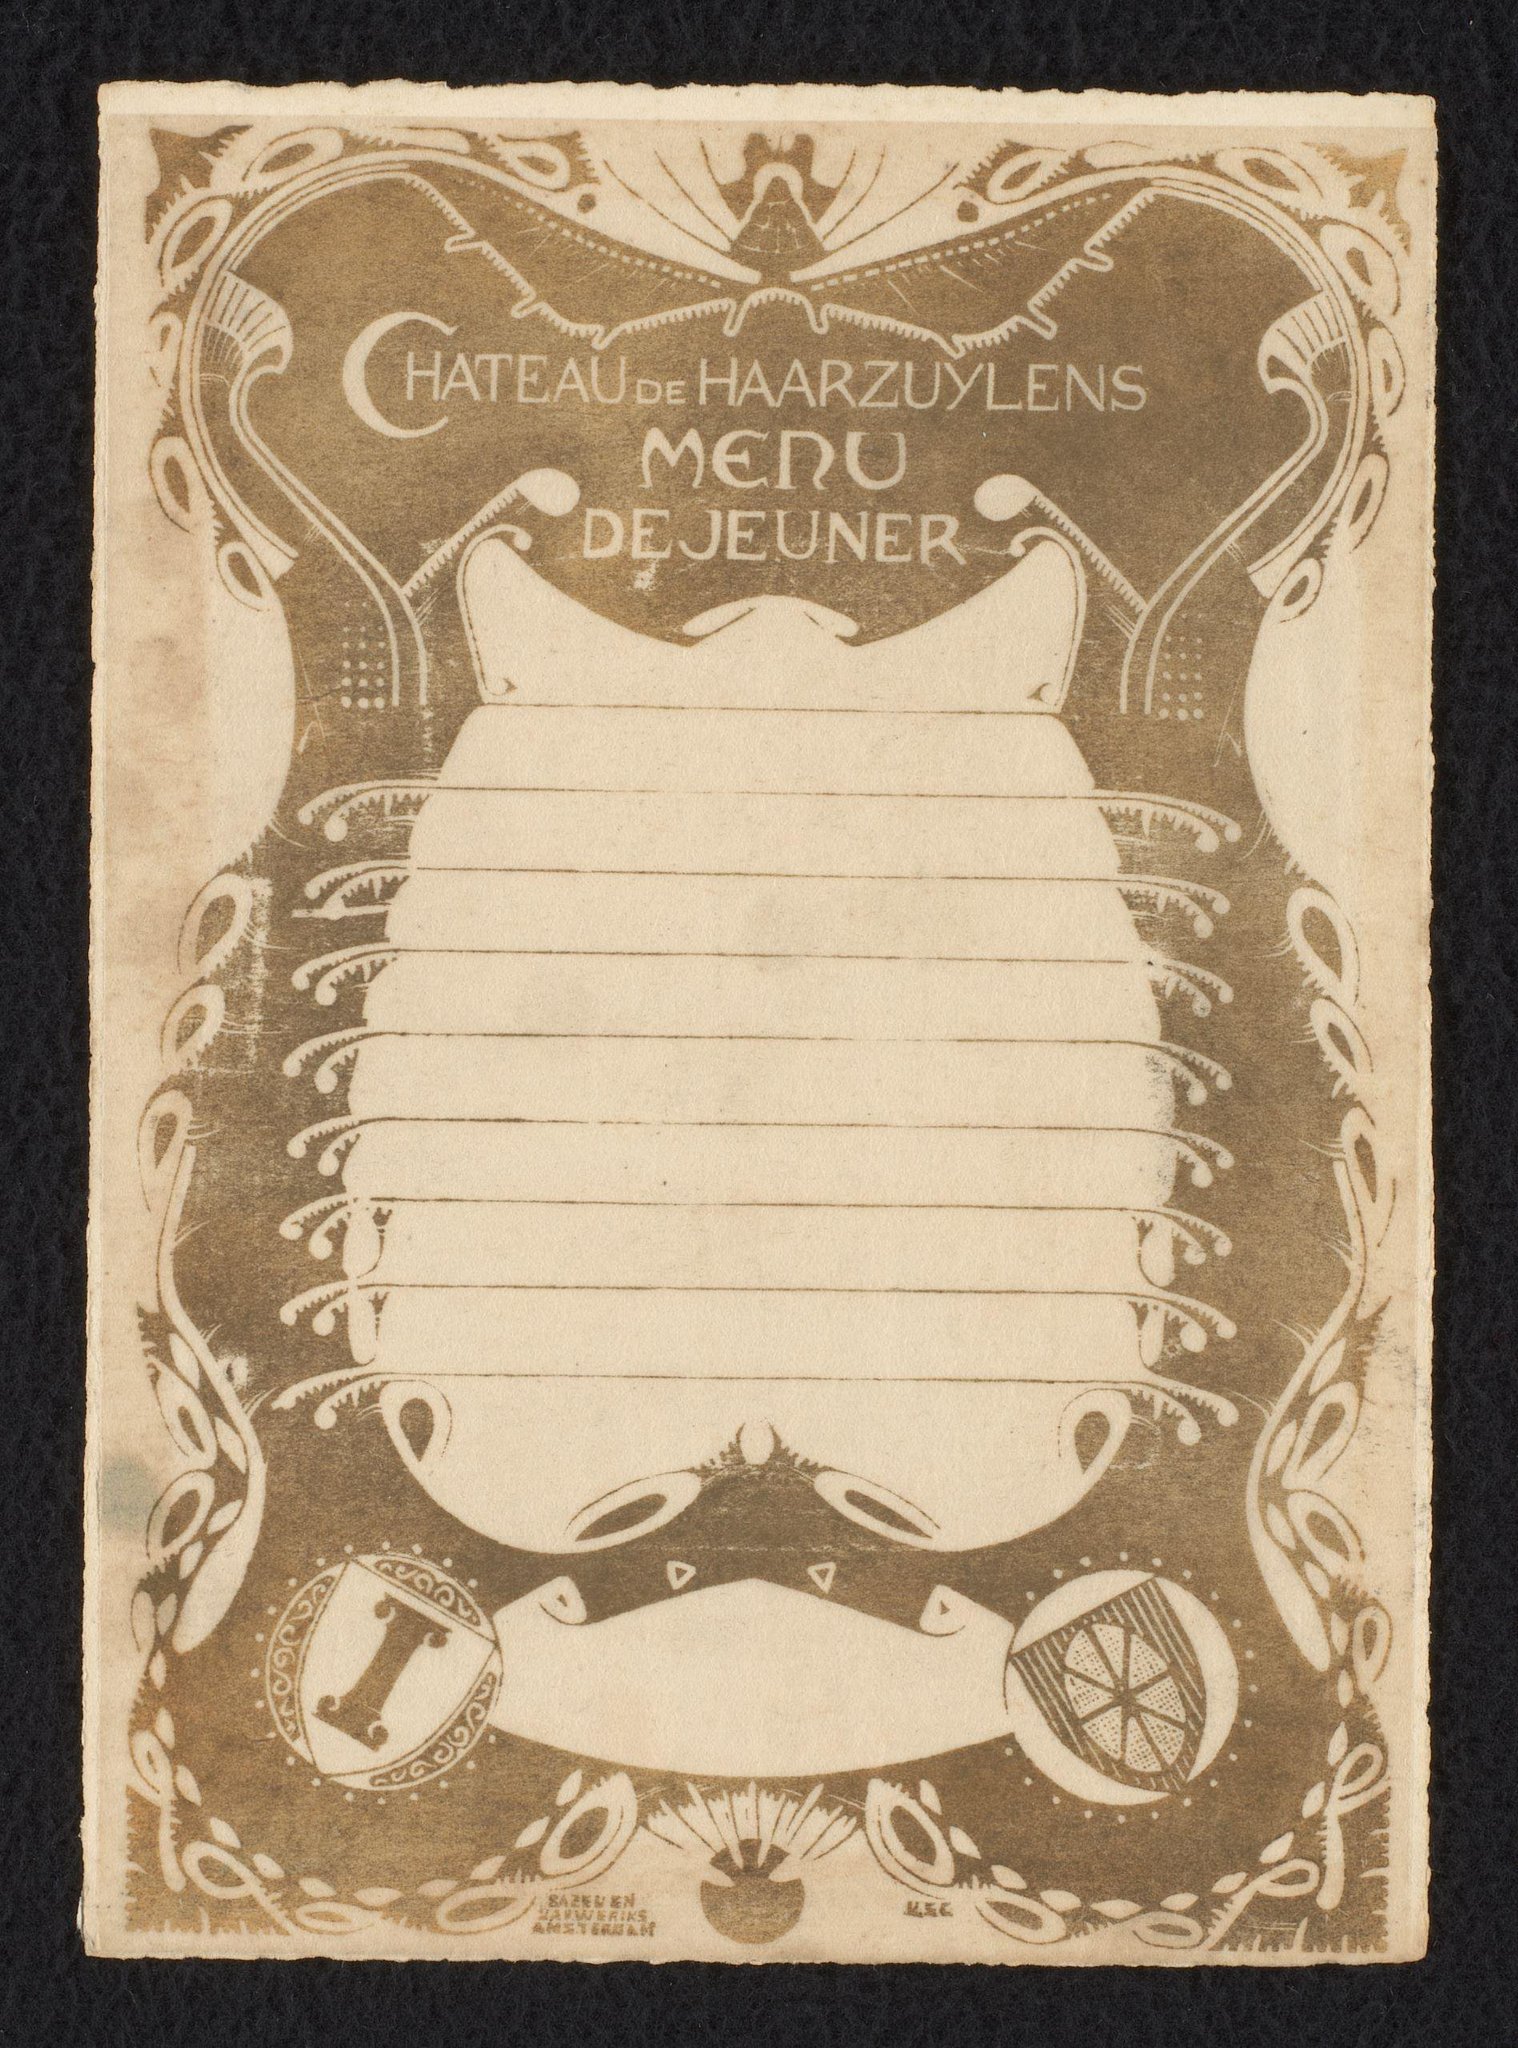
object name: print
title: Menukaart Château de Haarzuylens déjeuner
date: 1896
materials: paper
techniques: woodcut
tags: ornaments ~ art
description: Menukaart voor een ontbijt op kasteel De Haar in Haarzuilens.